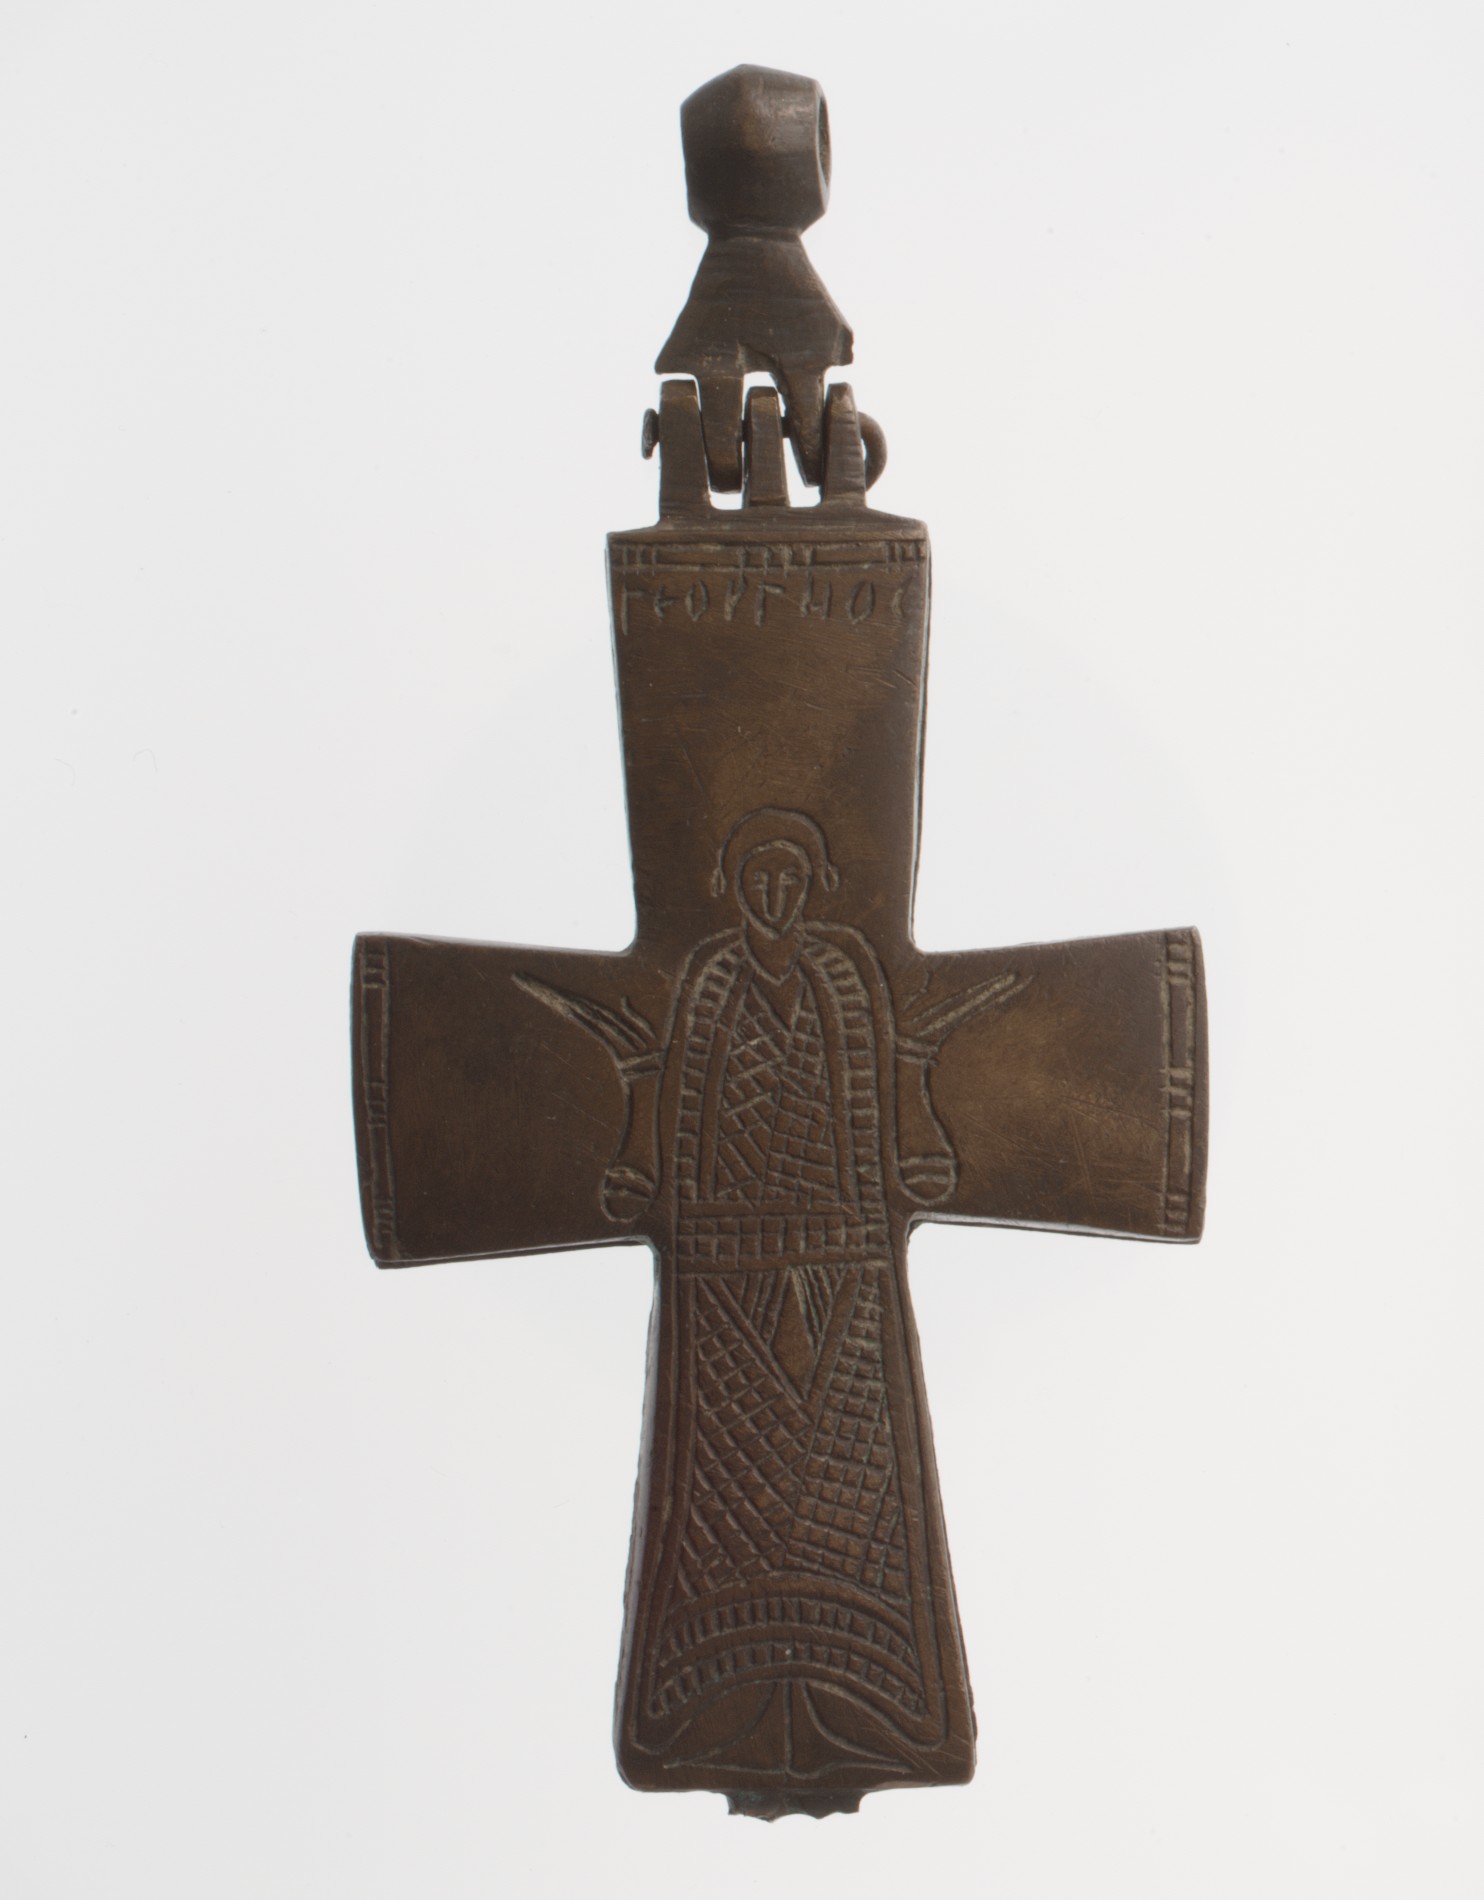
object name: reliquary cross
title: Reliquary Cross with Saint George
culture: byzantine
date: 800-1300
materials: copper alloy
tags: saint george